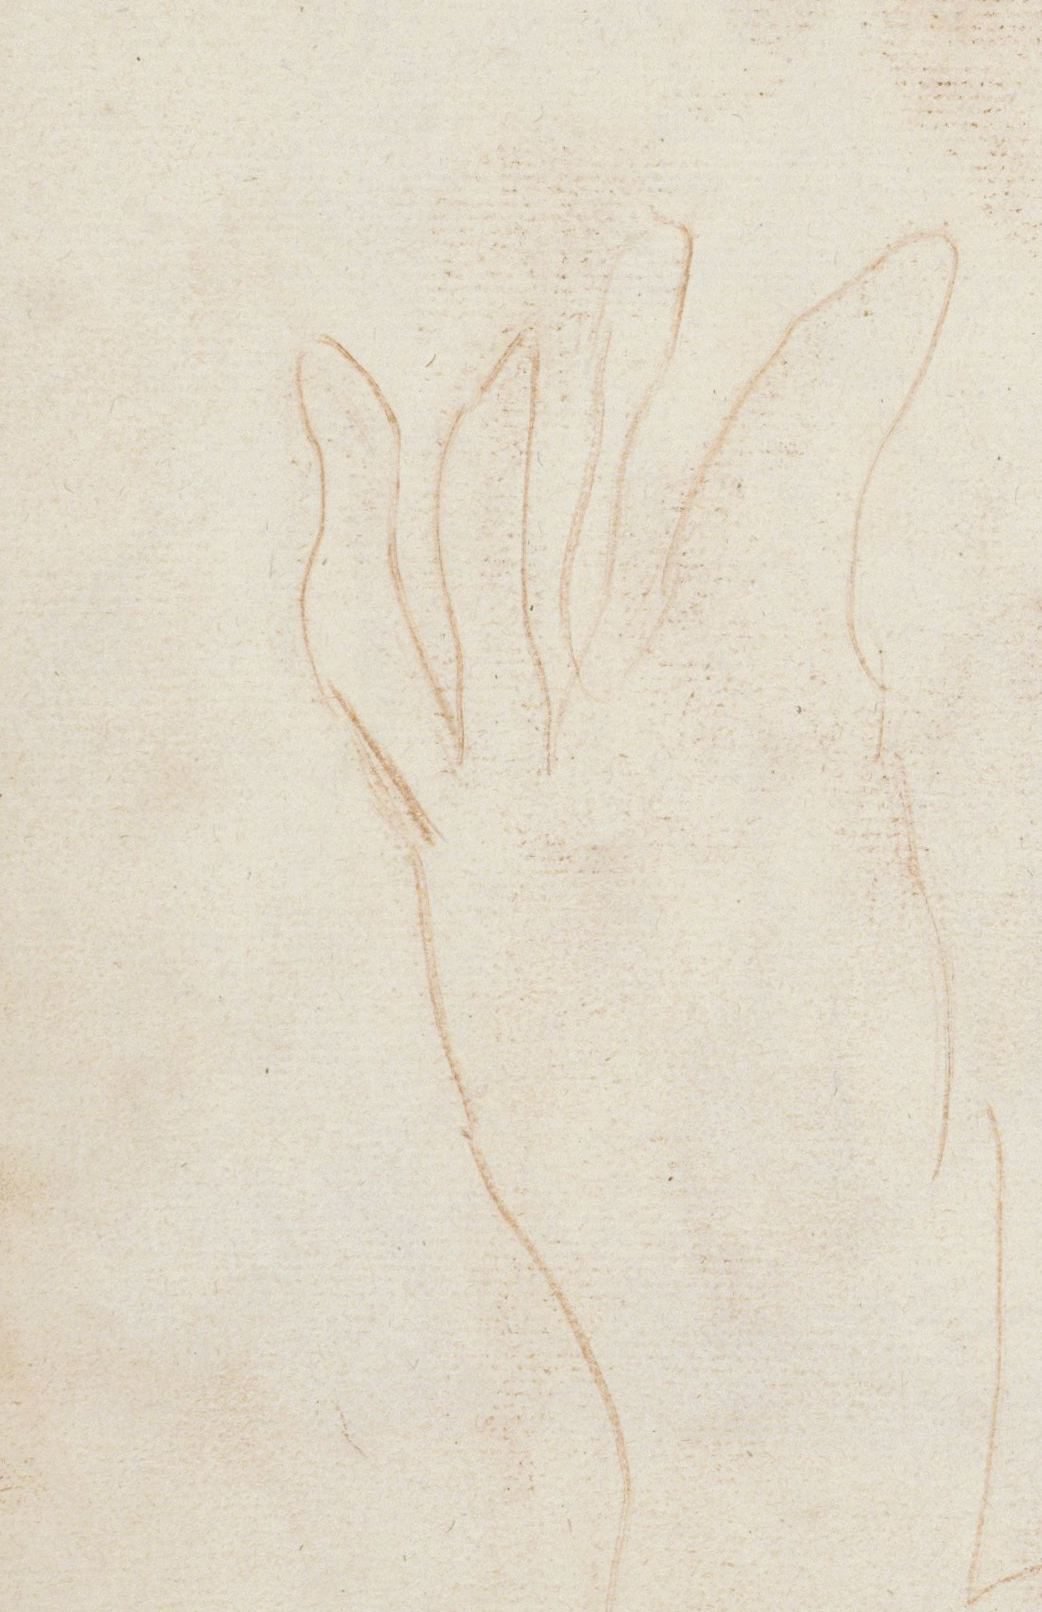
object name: sketchbook leaf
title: Hand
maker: petrus johannes van reysschoot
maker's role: draughtsman, print maker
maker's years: 1702-1772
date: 1710-1772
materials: chalk, paper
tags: hand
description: Blad 72 verso uit een schetsboek met 105 bladen.